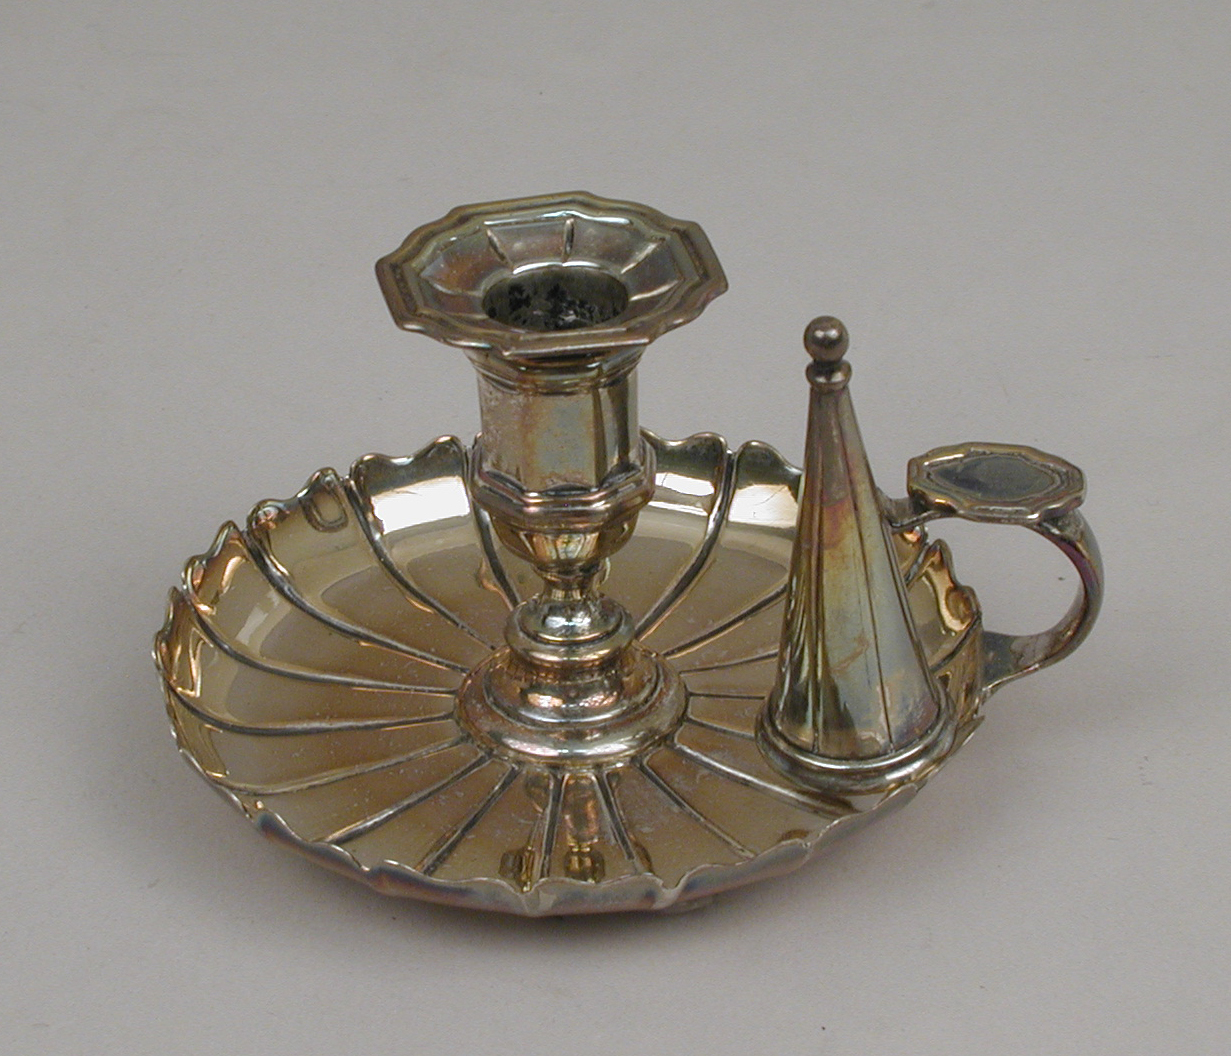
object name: chamber candlestick or taperstick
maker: john figg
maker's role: maker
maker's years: 1800-1900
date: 1849-1850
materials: silver